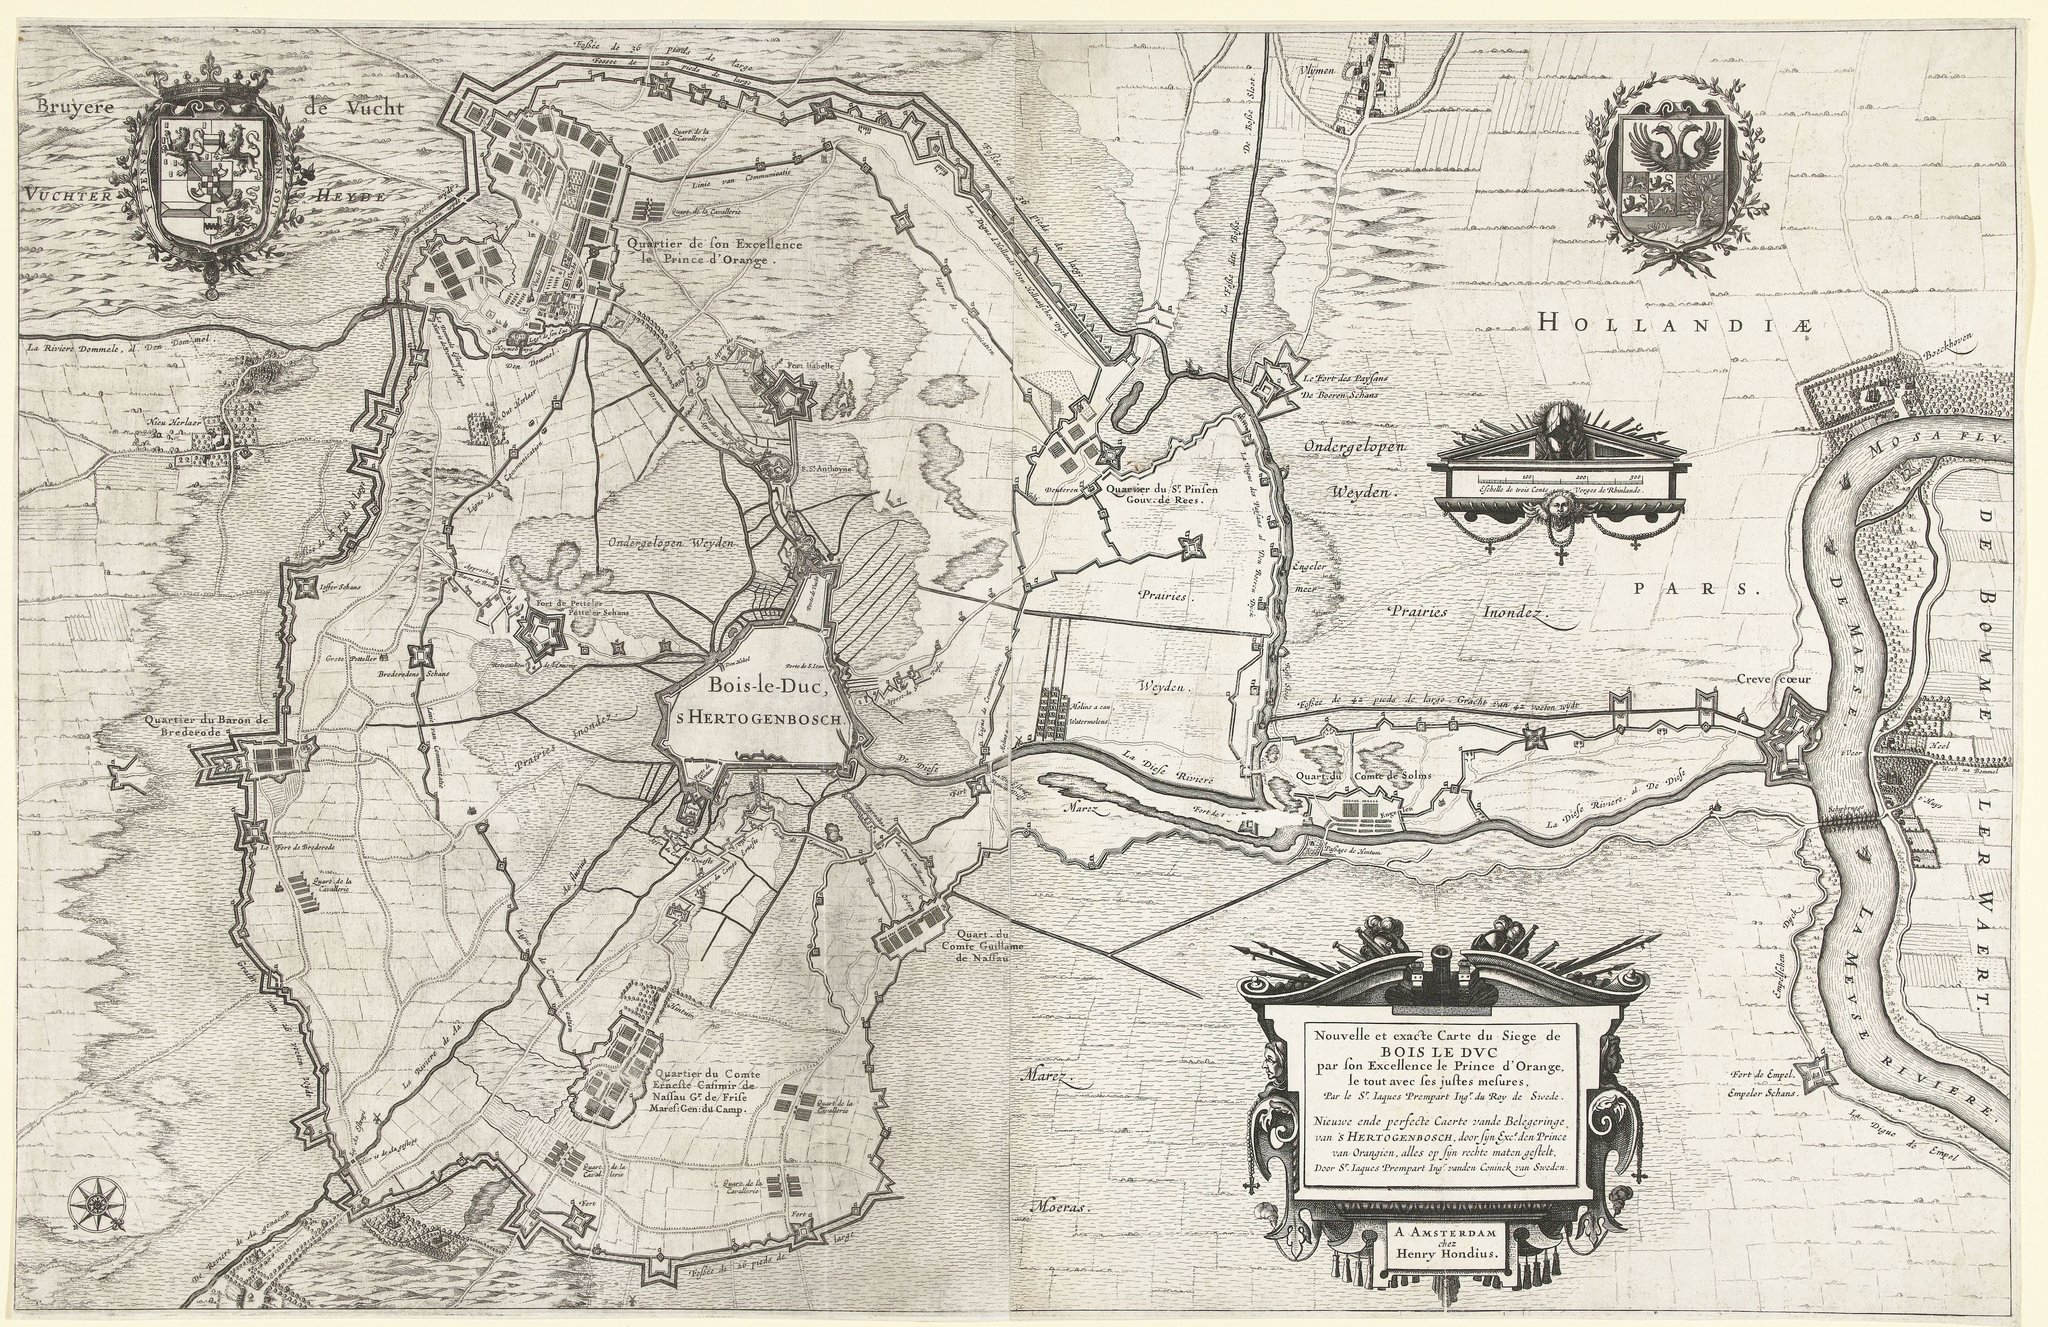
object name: map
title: Nouvelle et exacte Carte du Siege de Bois le Duc par son Excellence le Prince d'Orange (...)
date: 1629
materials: paper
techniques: etching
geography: northern netherlands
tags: frederick henry (prince of orange), maps of separate countries or regions, siege, position war, den bosch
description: Kaart van het beleg van Den Bosch door het Staatse leger onder Frederik Hendrik, van 1 mei tot 17 september 1629. Kaart met centraal de versterkte stad. Linksboven het wapen van stadhouder Frederik Hendrik, rechtsboven het wapen van Den Bosch. Rechtsonder een cartouche met de Franse en Nederlandse titels. Bij deze kaart behoren waarschijnlijk de zeven aparte kaarten van de Approches.